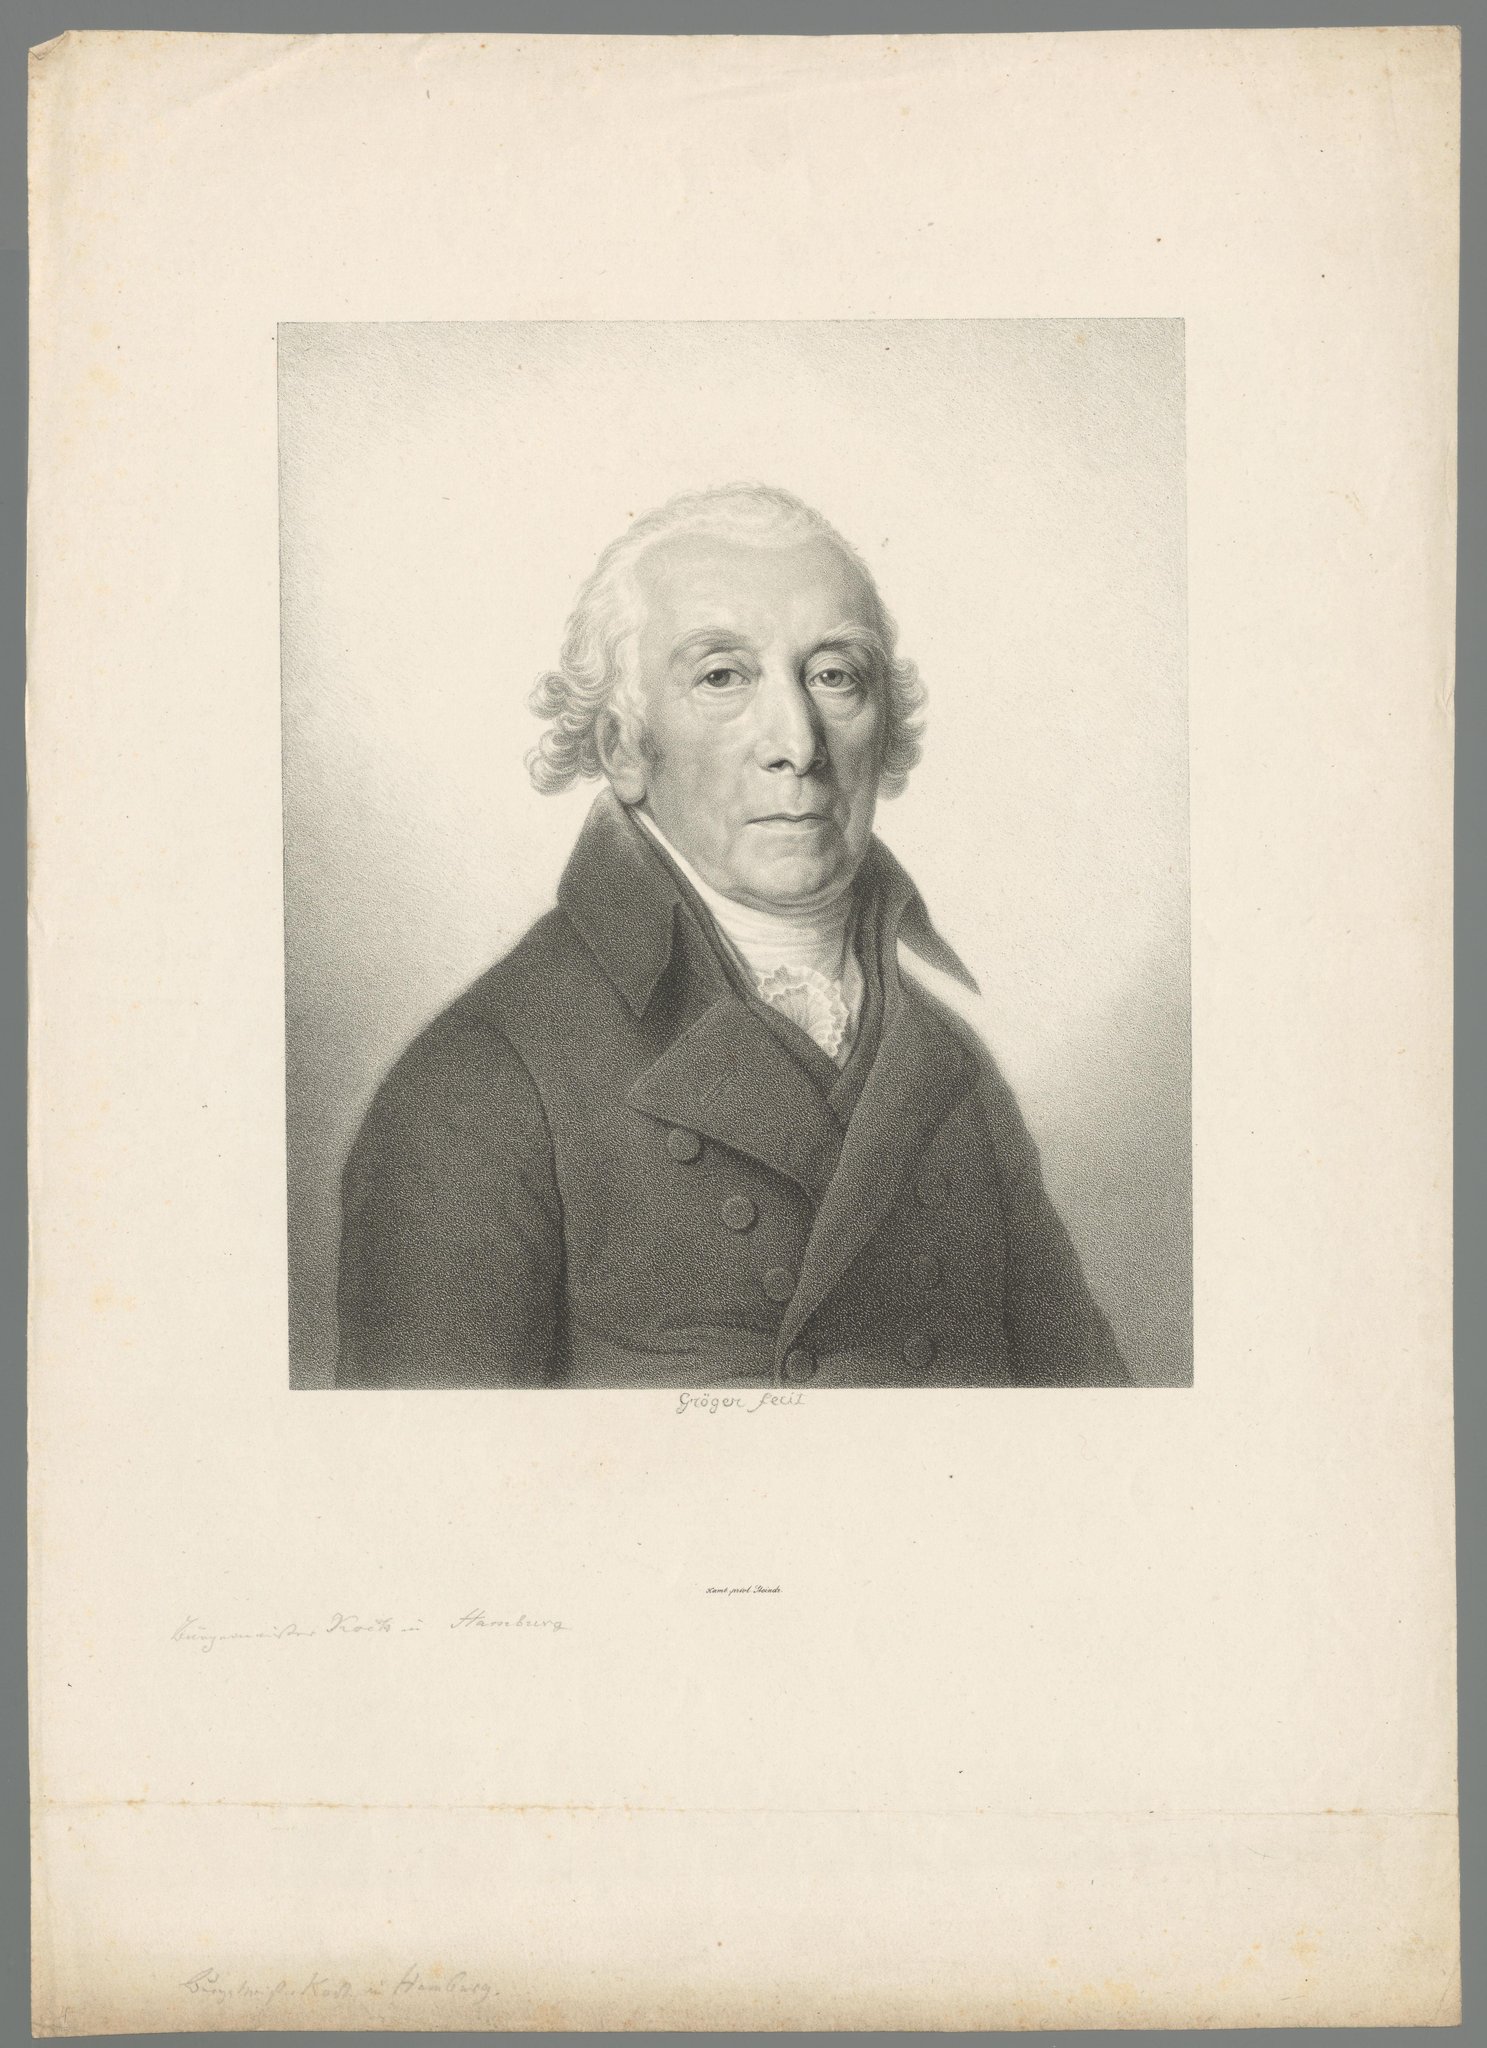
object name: print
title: Portret van een onbekende man, mogelijk Koch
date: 1800-1838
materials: paper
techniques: lithograph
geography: hamburg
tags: adult man, historical persons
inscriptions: collector's mark: Lugt 2228